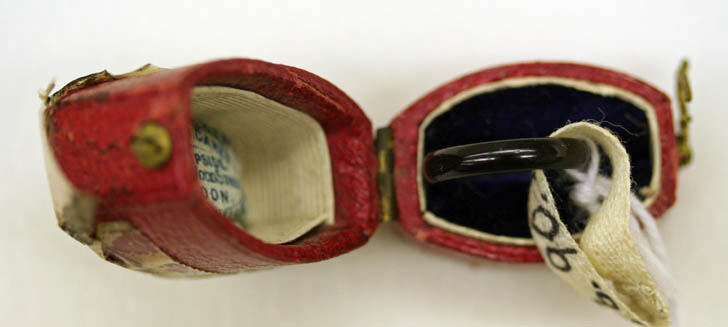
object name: mourning ring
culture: british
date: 1840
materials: leather, metal